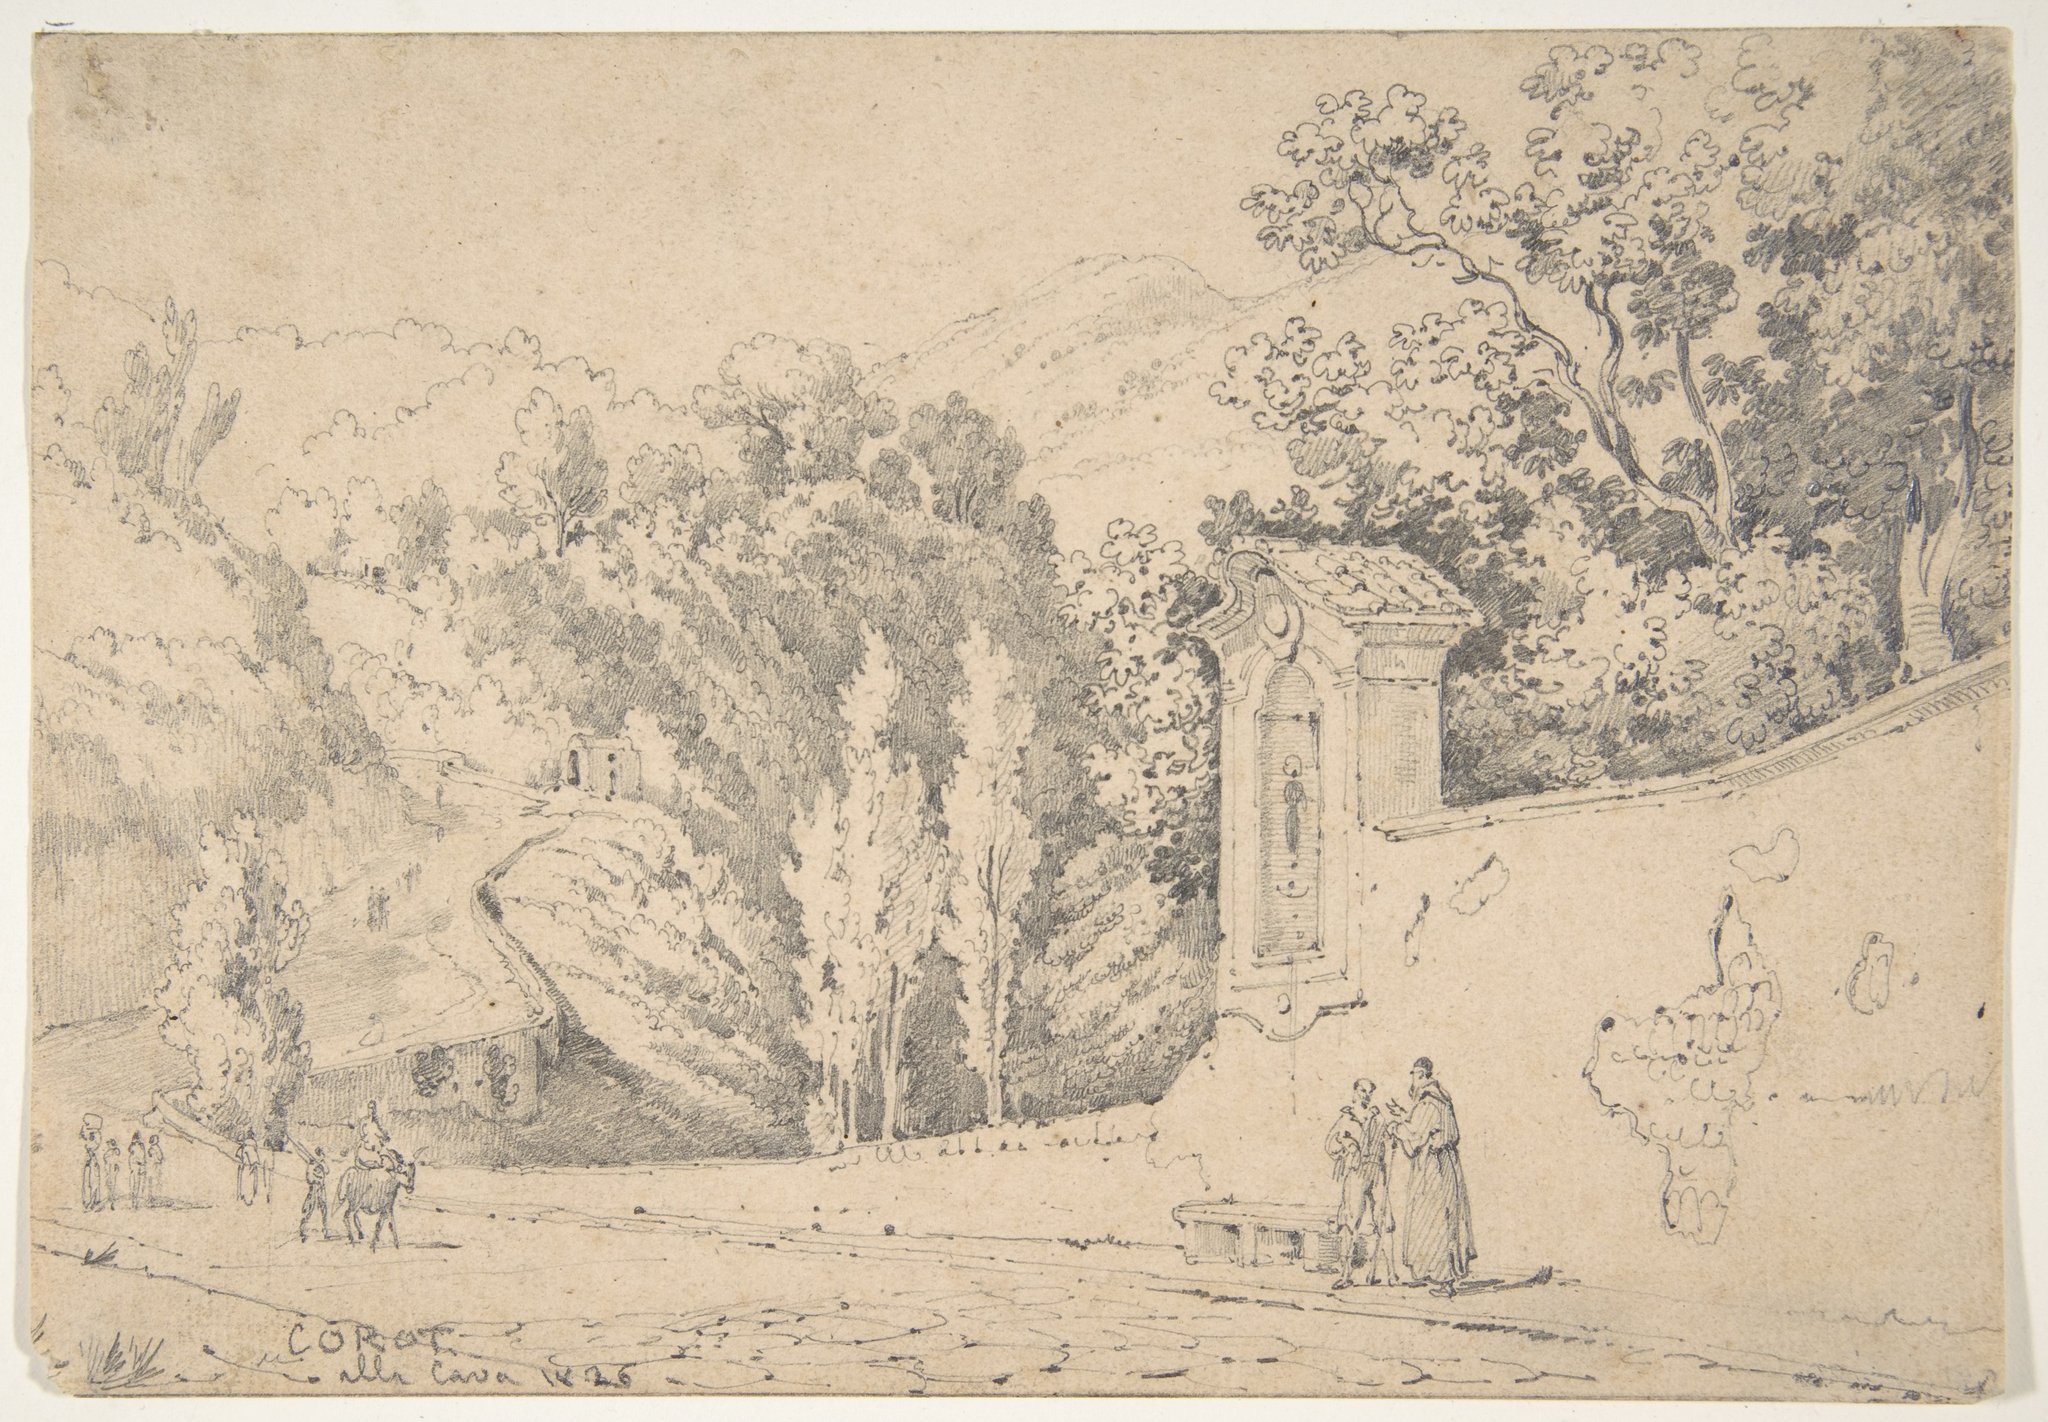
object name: drawing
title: Italian Landscape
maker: anonymous, french, 19th century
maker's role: artist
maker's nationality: french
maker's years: 1800-1900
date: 1801-1900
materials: graphite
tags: animals,roads,men,landscapes